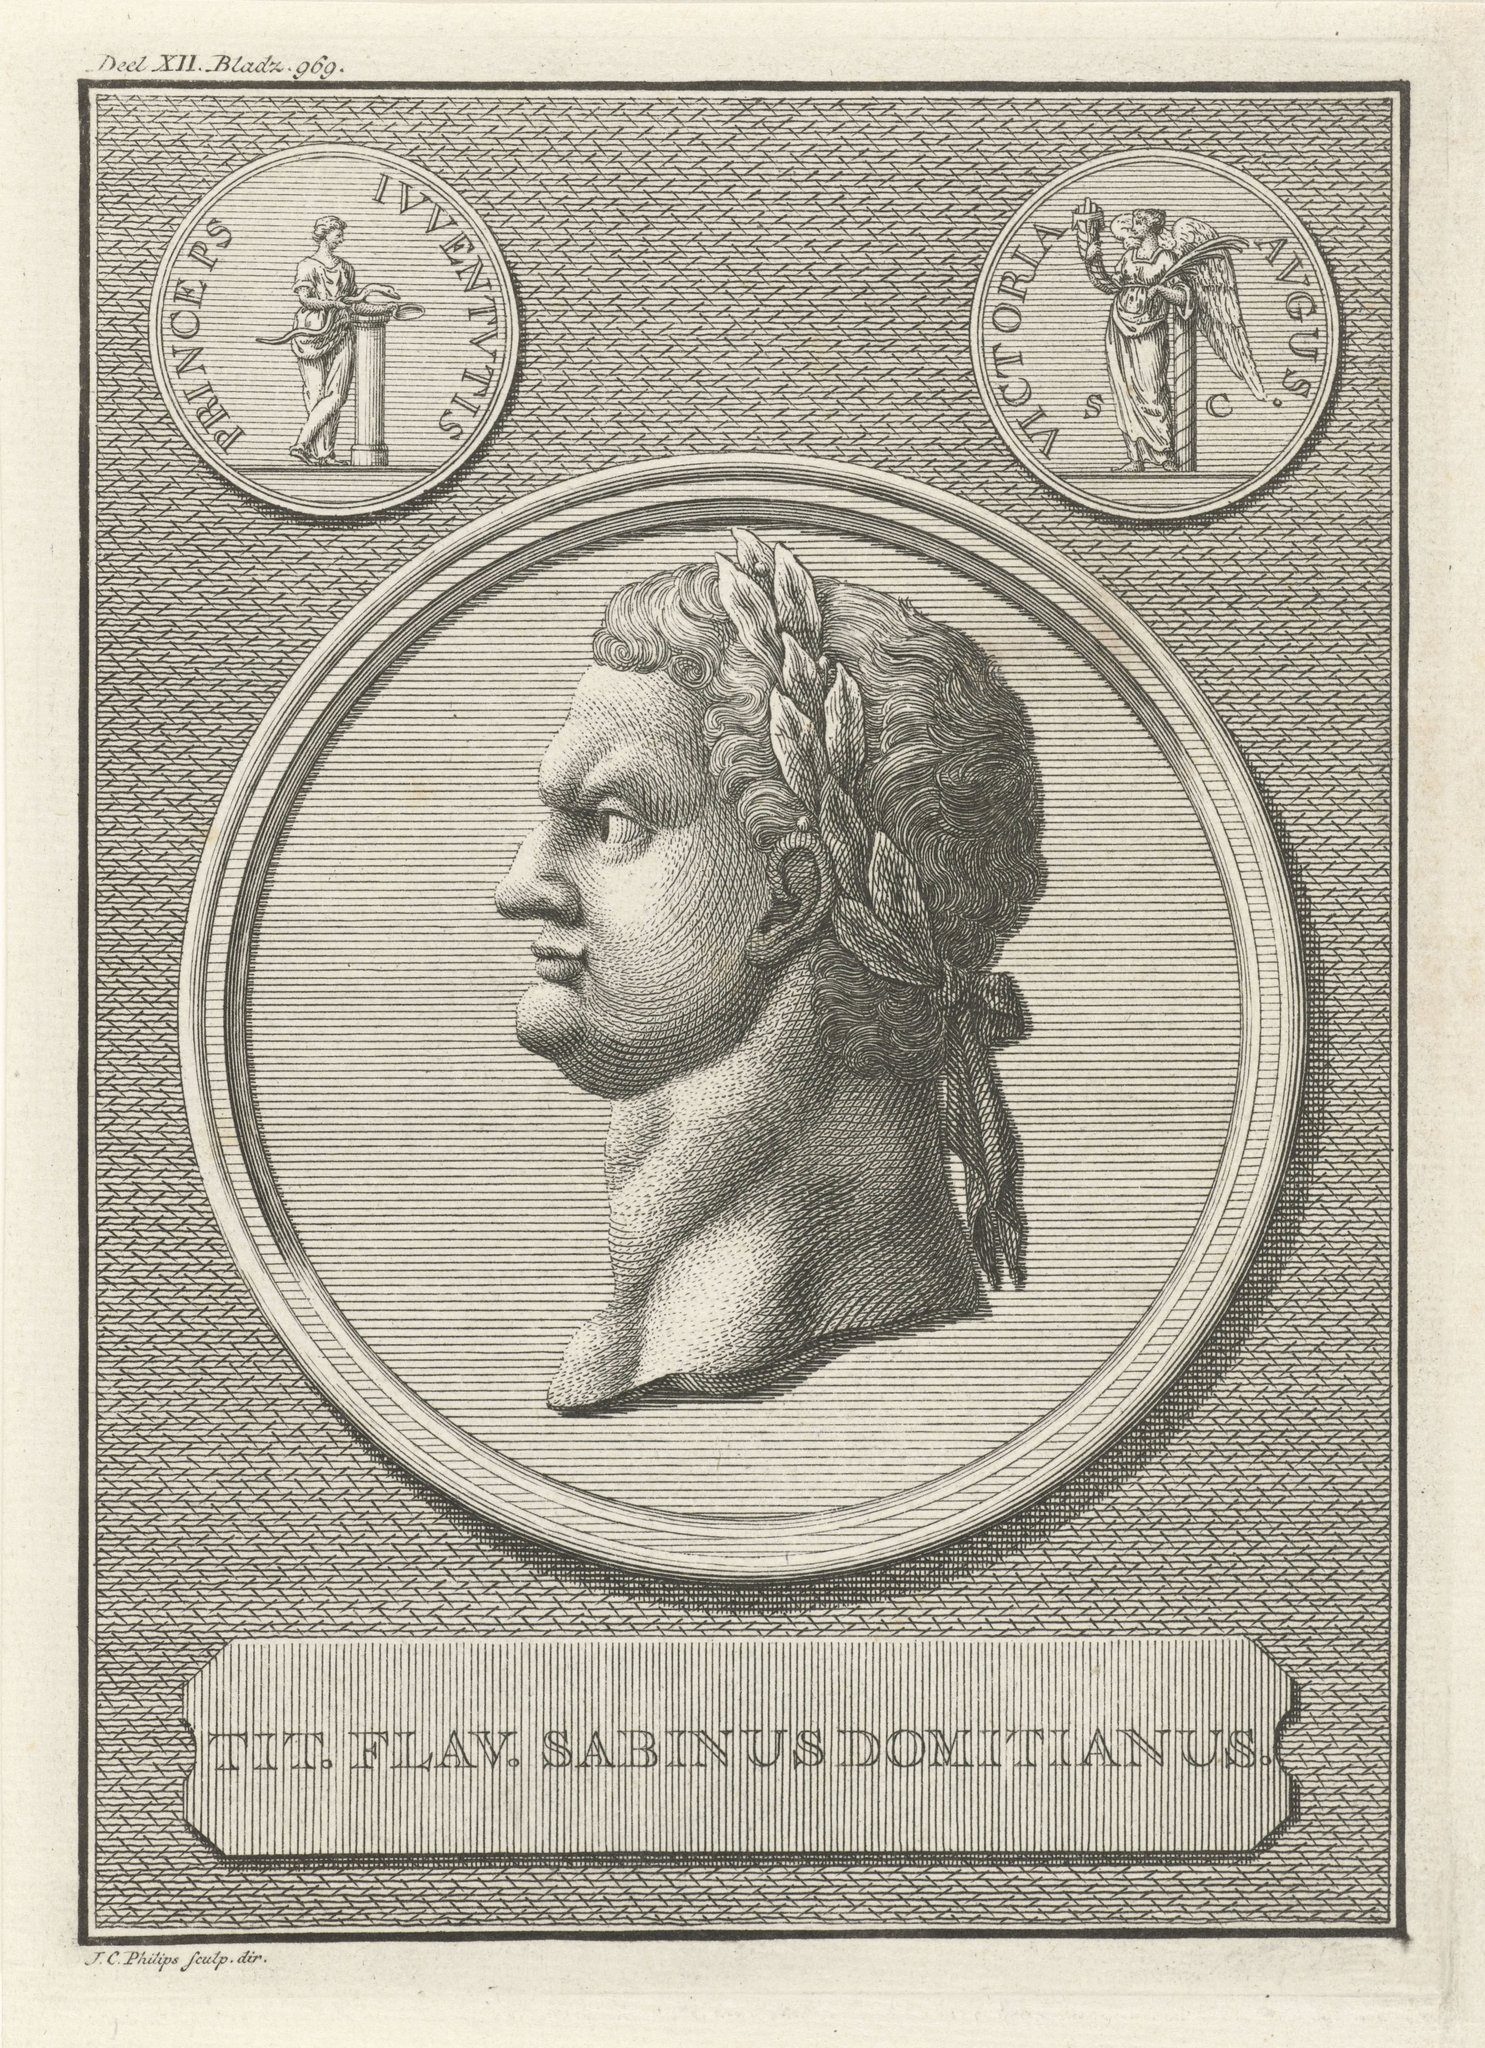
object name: print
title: Portret van keizer Titus Flavius Domitianus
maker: jan caspar philips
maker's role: draughtsman, print maker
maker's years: 1700-1775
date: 1746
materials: paper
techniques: engraving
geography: amsterdam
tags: coin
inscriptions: collector's mark: Lugt 2233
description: Prent gebruikt als illustratie in: Westerbaen, Kornelis, Algemeene histori van het begin der wereld af tot den tegenwoordigen tijd toe, deel XII. Utrecht: Herman Besseling, 1746.